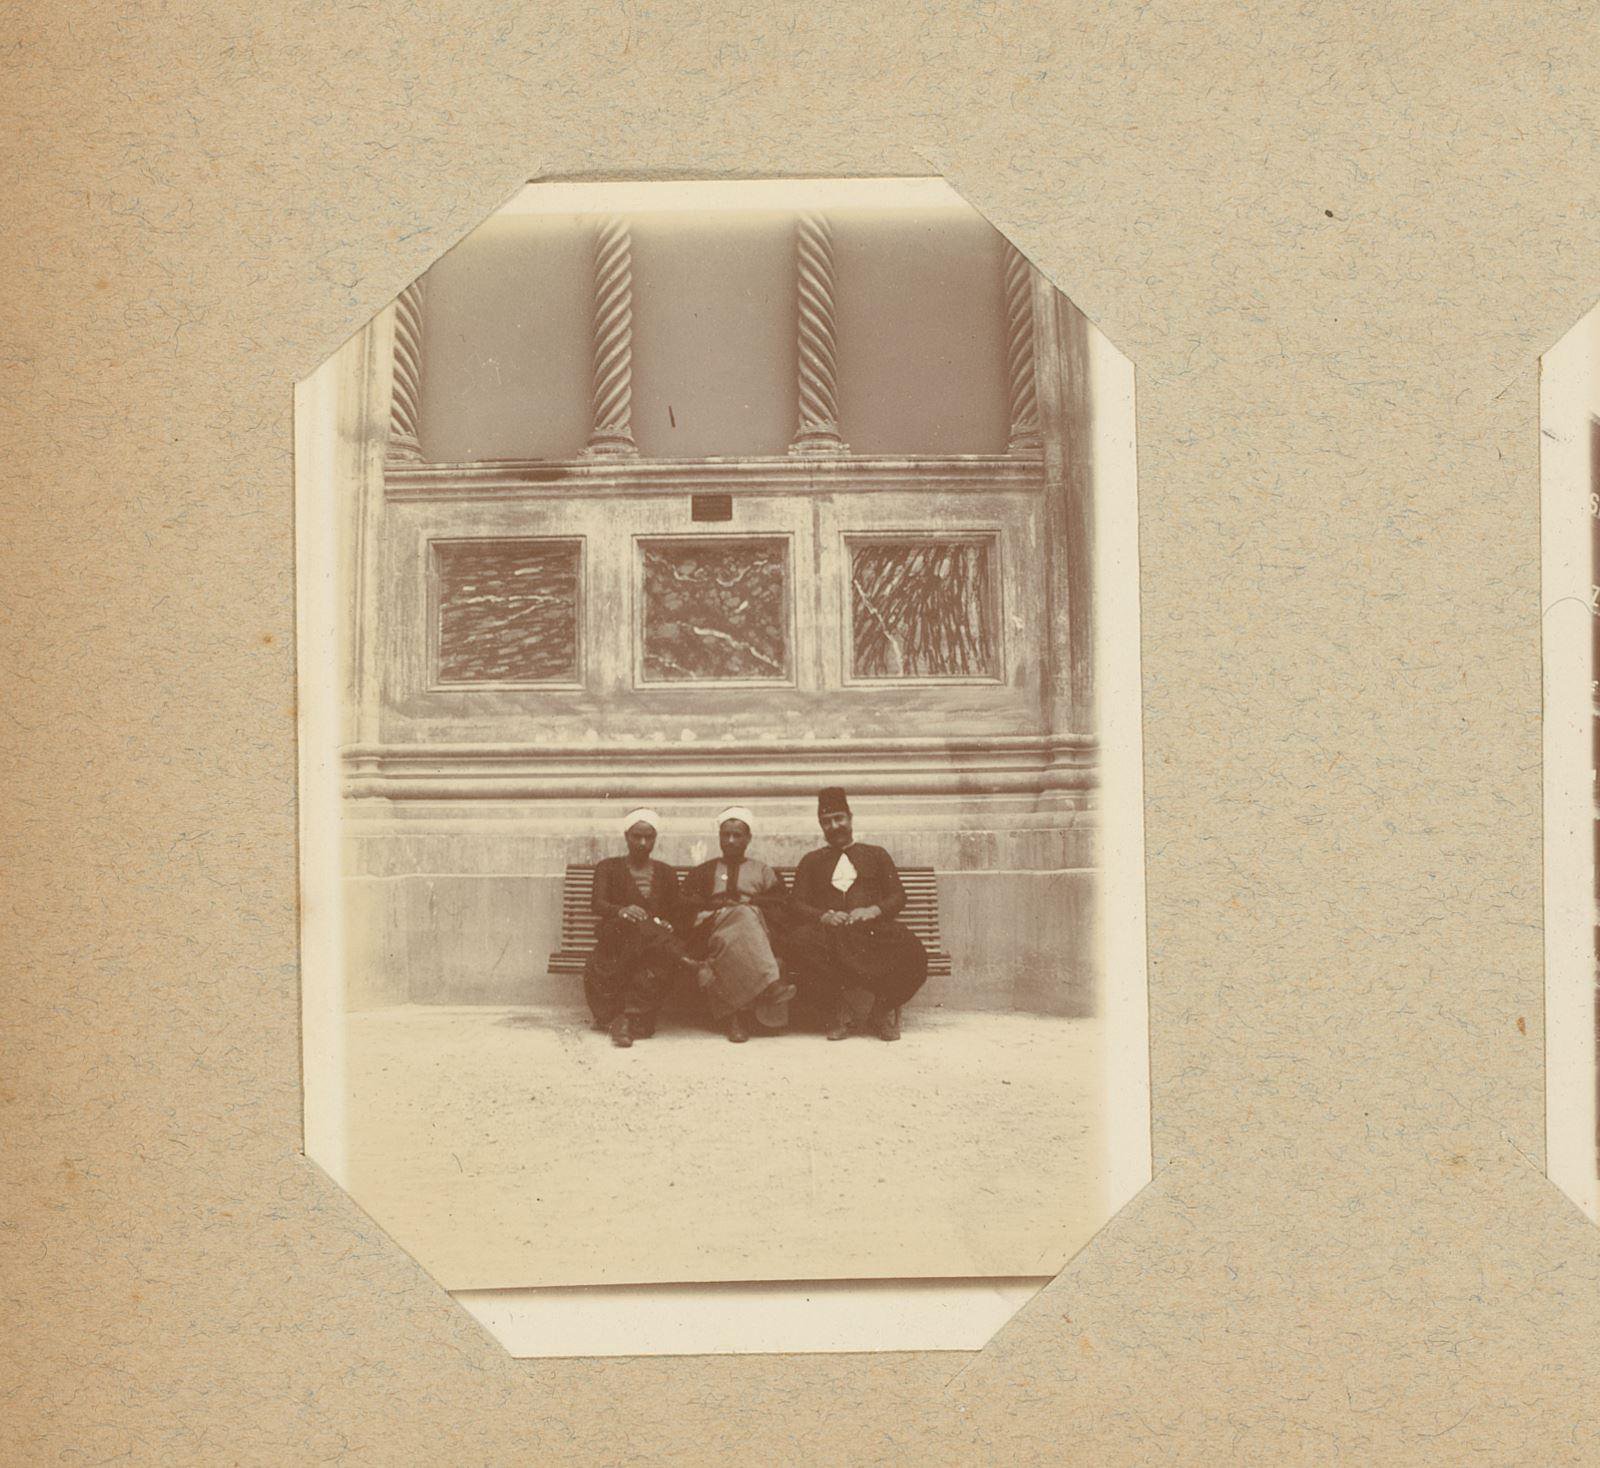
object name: photograph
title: Drie mannen met tulband en fez op de Wereldtentoonstelling van 1900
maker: Anonymous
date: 1900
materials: paper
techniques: gelatin silver print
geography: paris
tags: world fair, world exhibition, paris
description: Over de foto is een ander negatief afgedrukt van een voorstelling van bomen.